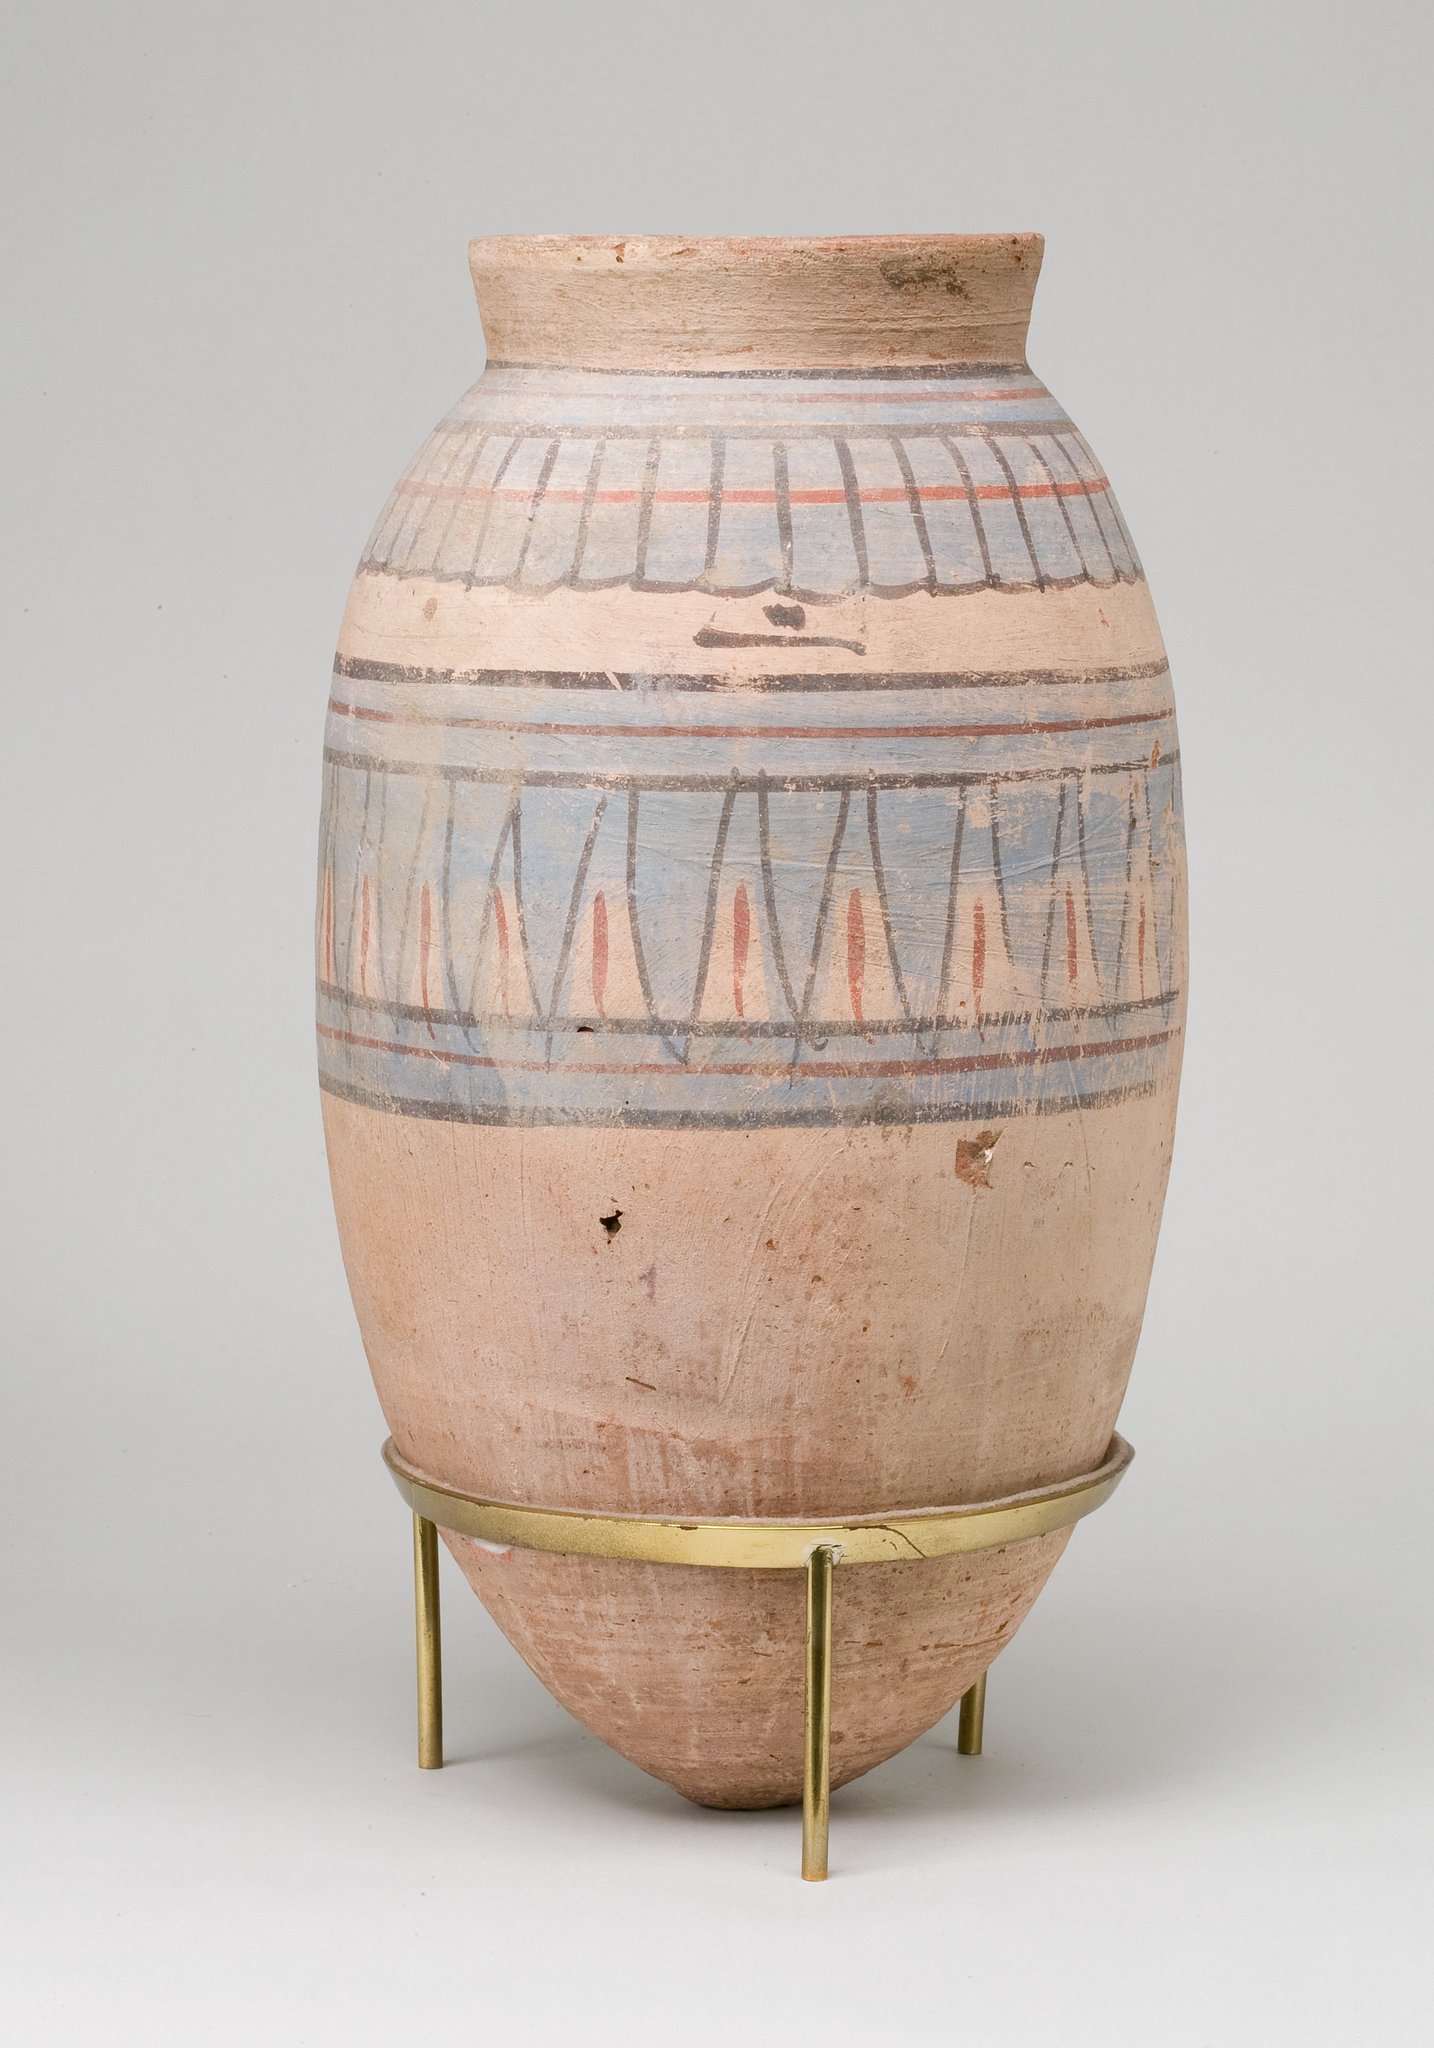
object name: jar, blue painted, malqata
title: Blue-Painted Jar from Malqata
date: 1390-1352 BCE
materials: paint, pottery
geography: egypt